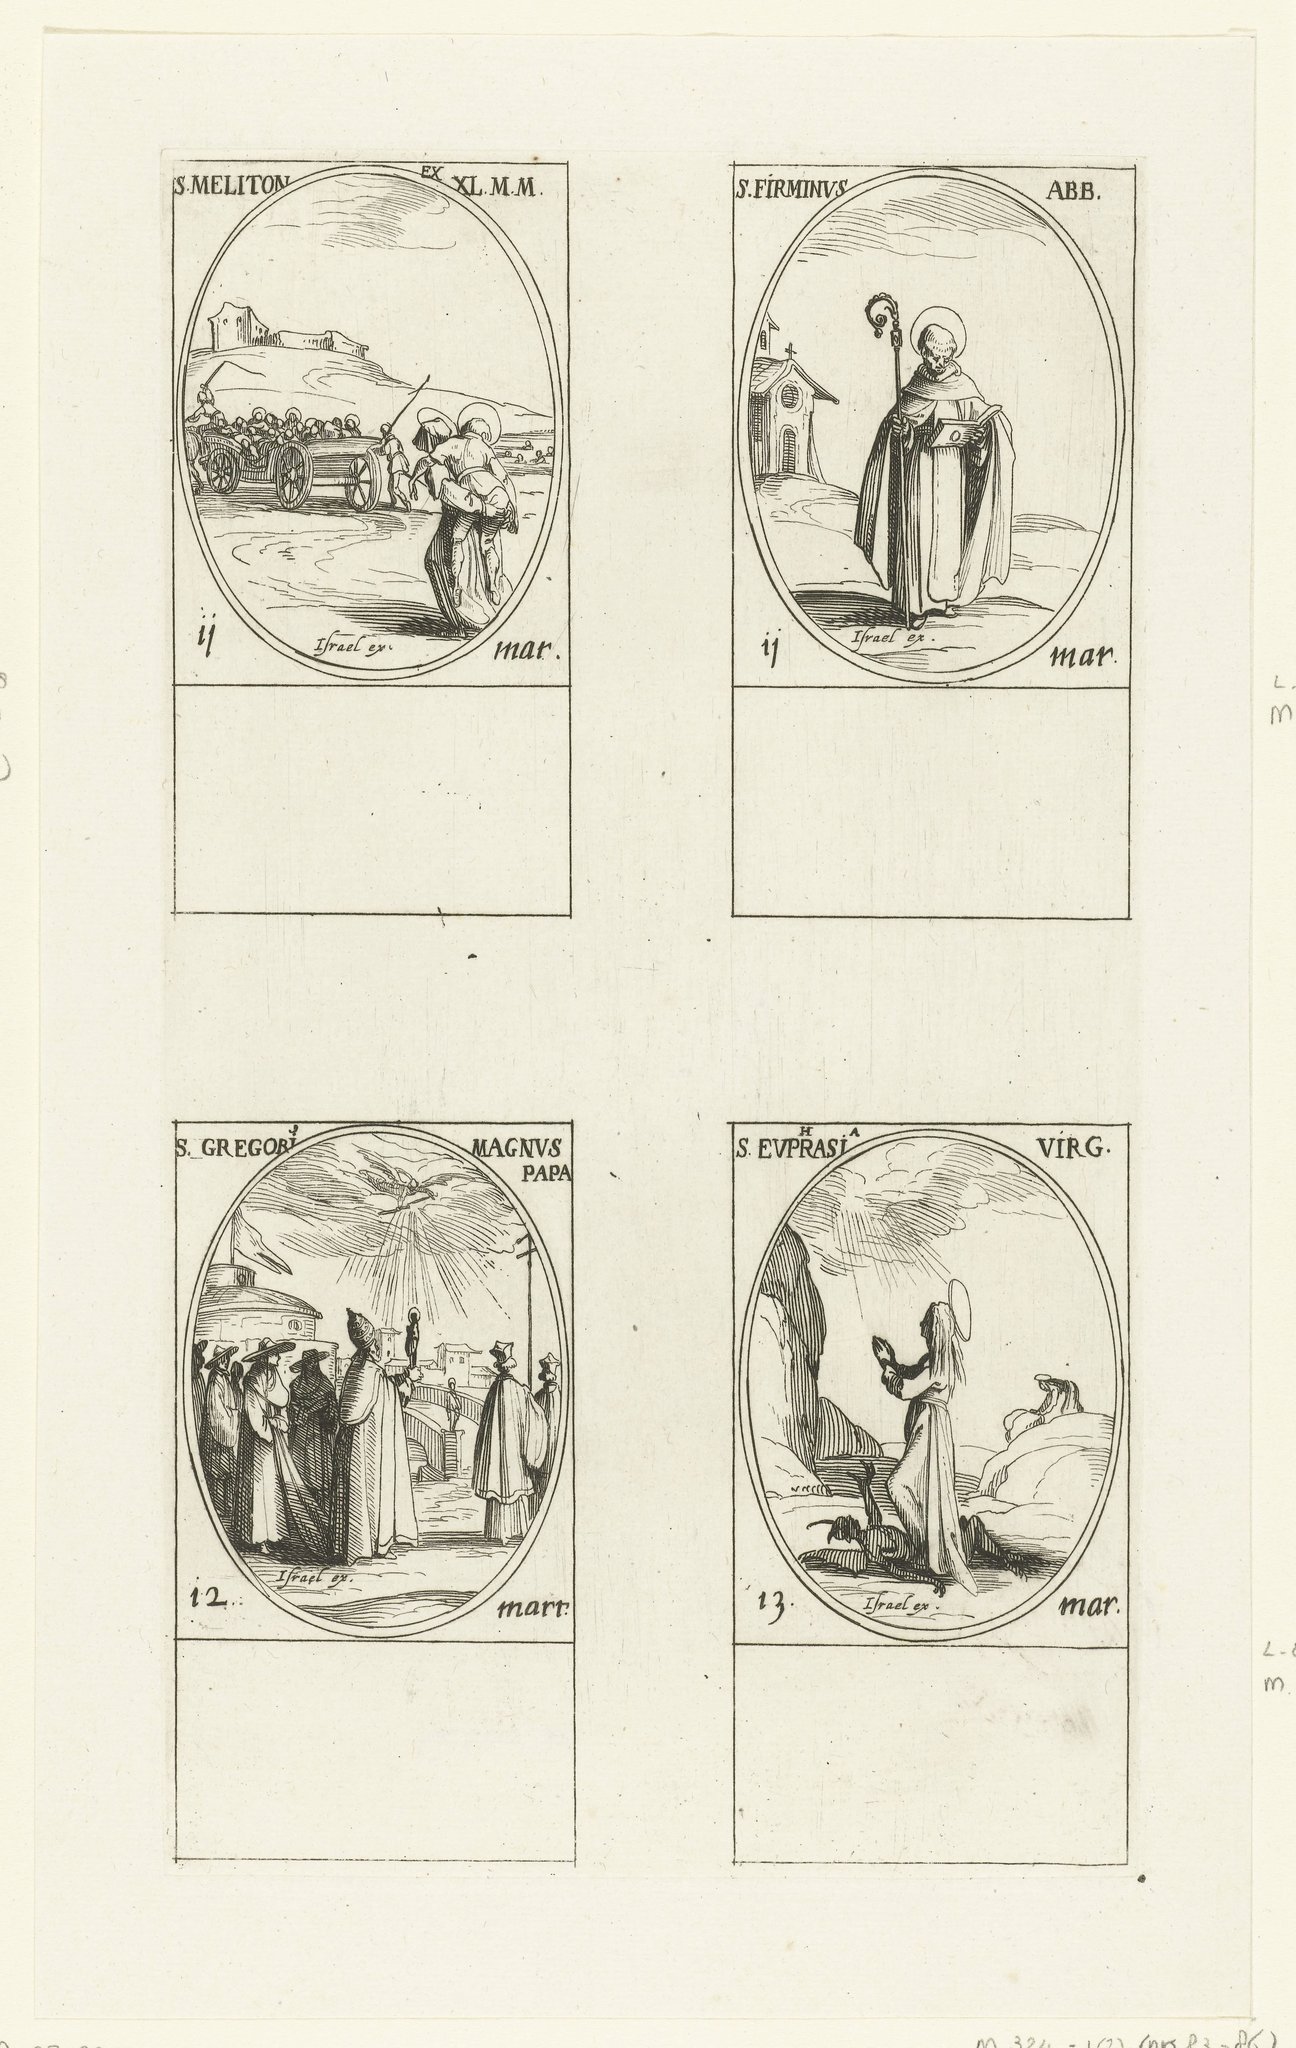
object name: print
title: Heilige Meliton, Heilige Firminus, Heilige Gregorius I de Grote, Heilige Euphrasia van Constantinopel (11-13 maart)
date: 1632-1636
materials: paper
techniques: etching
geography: nancy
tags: female saints (with name), st. gregory the great leading a procession during the plague in rome; the archangel michael with drawn sword appears above the mausoleum of hadrian, male saints (with name)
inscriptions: collector's mark: Lugt 240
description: Blad met vier ovale voorstellingen, elk met opschrift en datum in het Latijn: linksboven de Heilige Meliton die een kind op zijn rug draagt, rechtsboven de Heilige Firminus met een staf en een boek in de handen, linksonder de Heilige paus Gregorius de Grote die een engel bij de Engelenburcht in Rome ziet, rechtsonder de Heilige Euphrasia die al biddend een demon of duivel vertrapt. Deze prent is onderdeel van een serie prenten met voorstellingen van de heiligen en de christelijke feestdagen van het jaar. Er zijn steeds vier scènes van één plaat op één blad gedrukt. Inclusief bijbehorend titelblad en frontispice gaat het in totaal om 124 platen (490 voorstellingen). De drie platen met de laatste 12 scènes (de veranderlijke christelijke feestdagen) zijn in de derde staat versneden tot 12 kleine plaatjes, en met een apart titelblad uitgegeven.